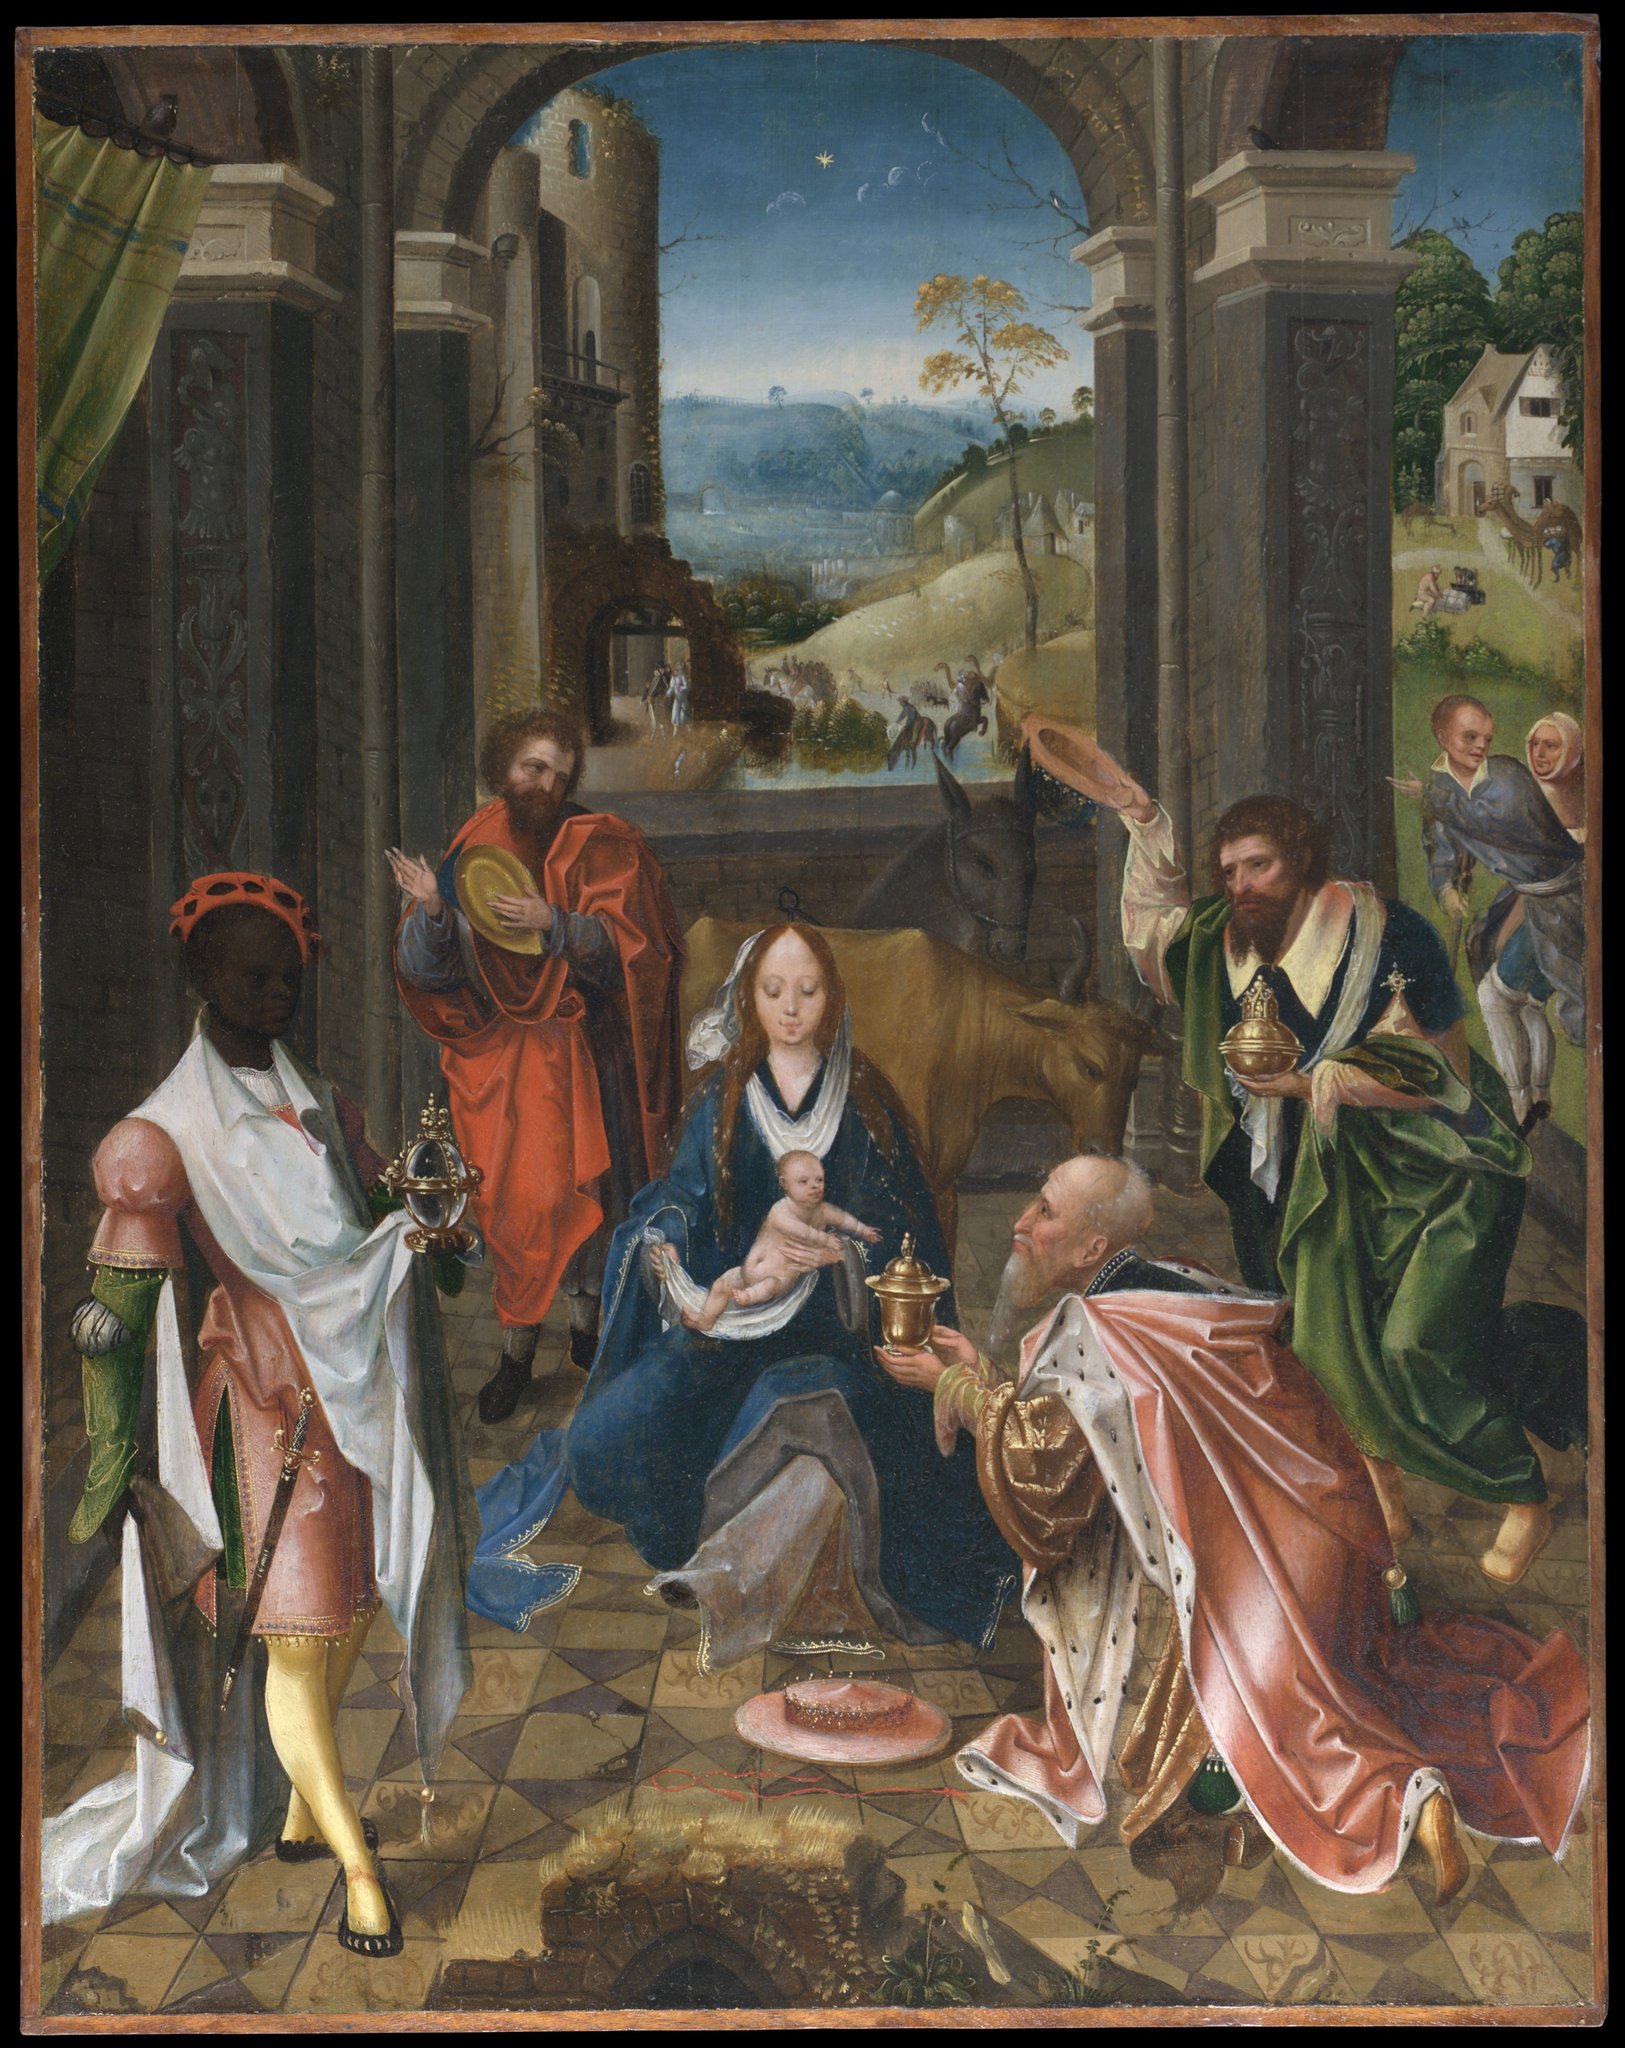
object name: painting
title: The Adoration of the Magi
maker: netherlandish (antwerp mannerist) painter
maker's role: artist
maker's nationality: netherlandish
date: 1515-1525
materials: oil, wood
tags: virgin mary,jesus,adoration of the magi,joseph